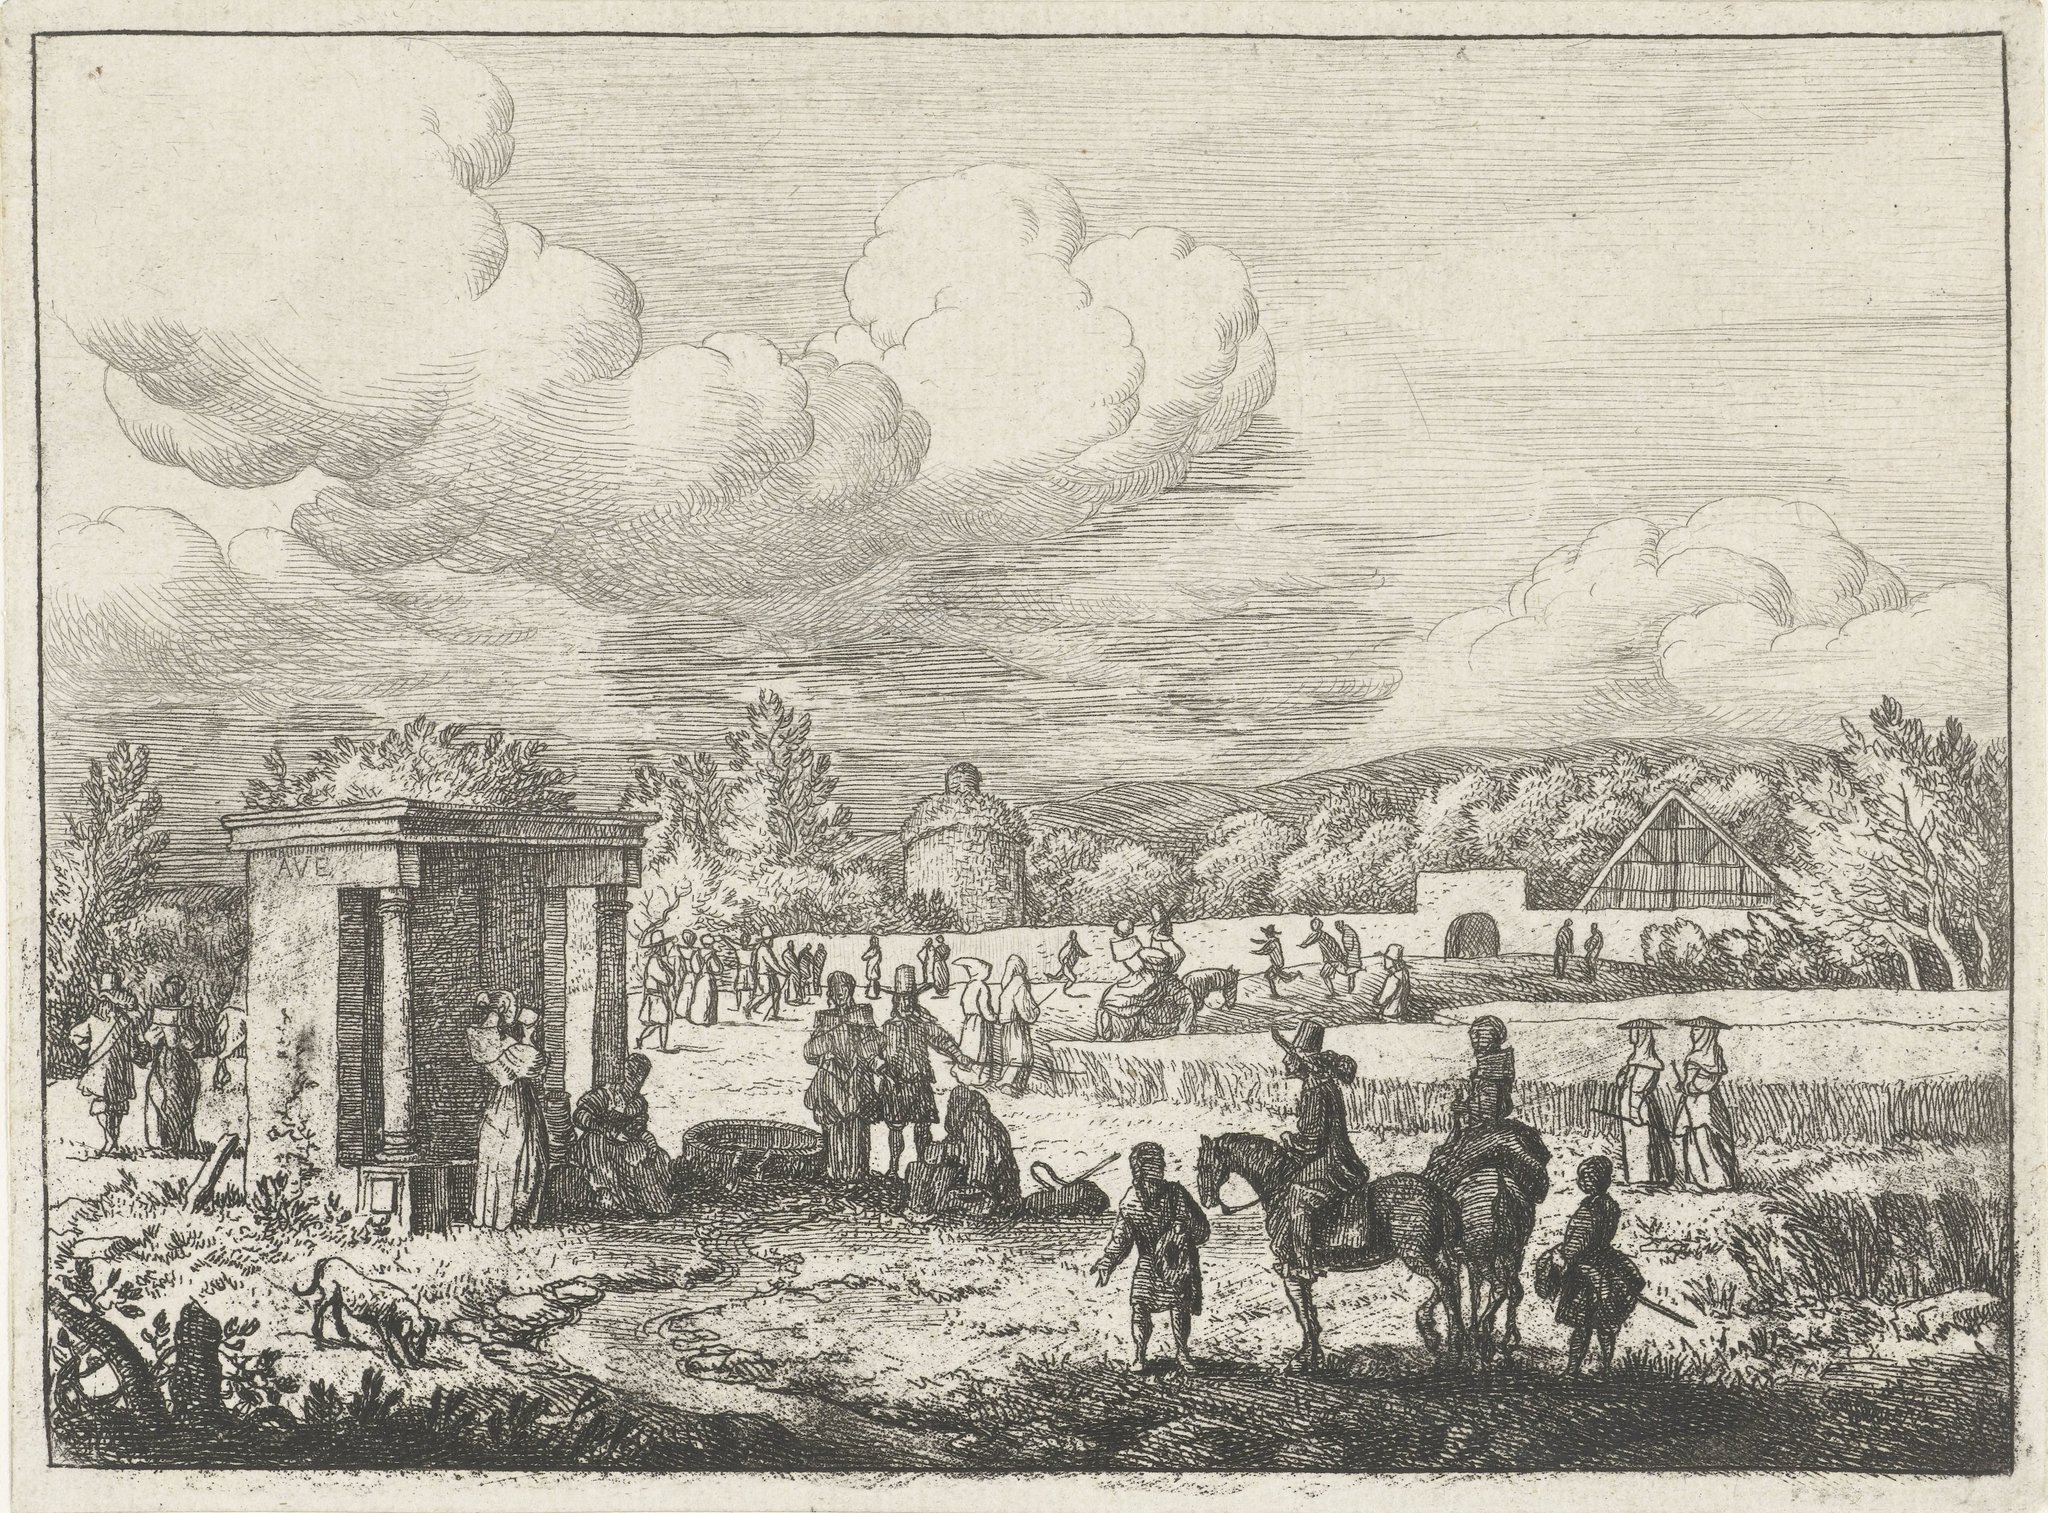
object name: print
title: Vier waterbronnen in en rond Spa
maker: allaert van everdingen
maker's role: draughtsman, painter, print maker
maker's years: 1621-1675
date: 1631-1675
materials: paper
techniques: etching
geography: netherlands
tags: spring (fluids extracted from the earth)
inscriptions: collector's mark: Lugt 2228, collector's mark: Lugt 1904, collector's mark: Lugt 2760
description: Een landschap met een korenveld en verschillende personen in voet en te paard. Op de voorgrond twee ruiters en twee staande personen bij een stroompje afkomstig uit een waterbron.